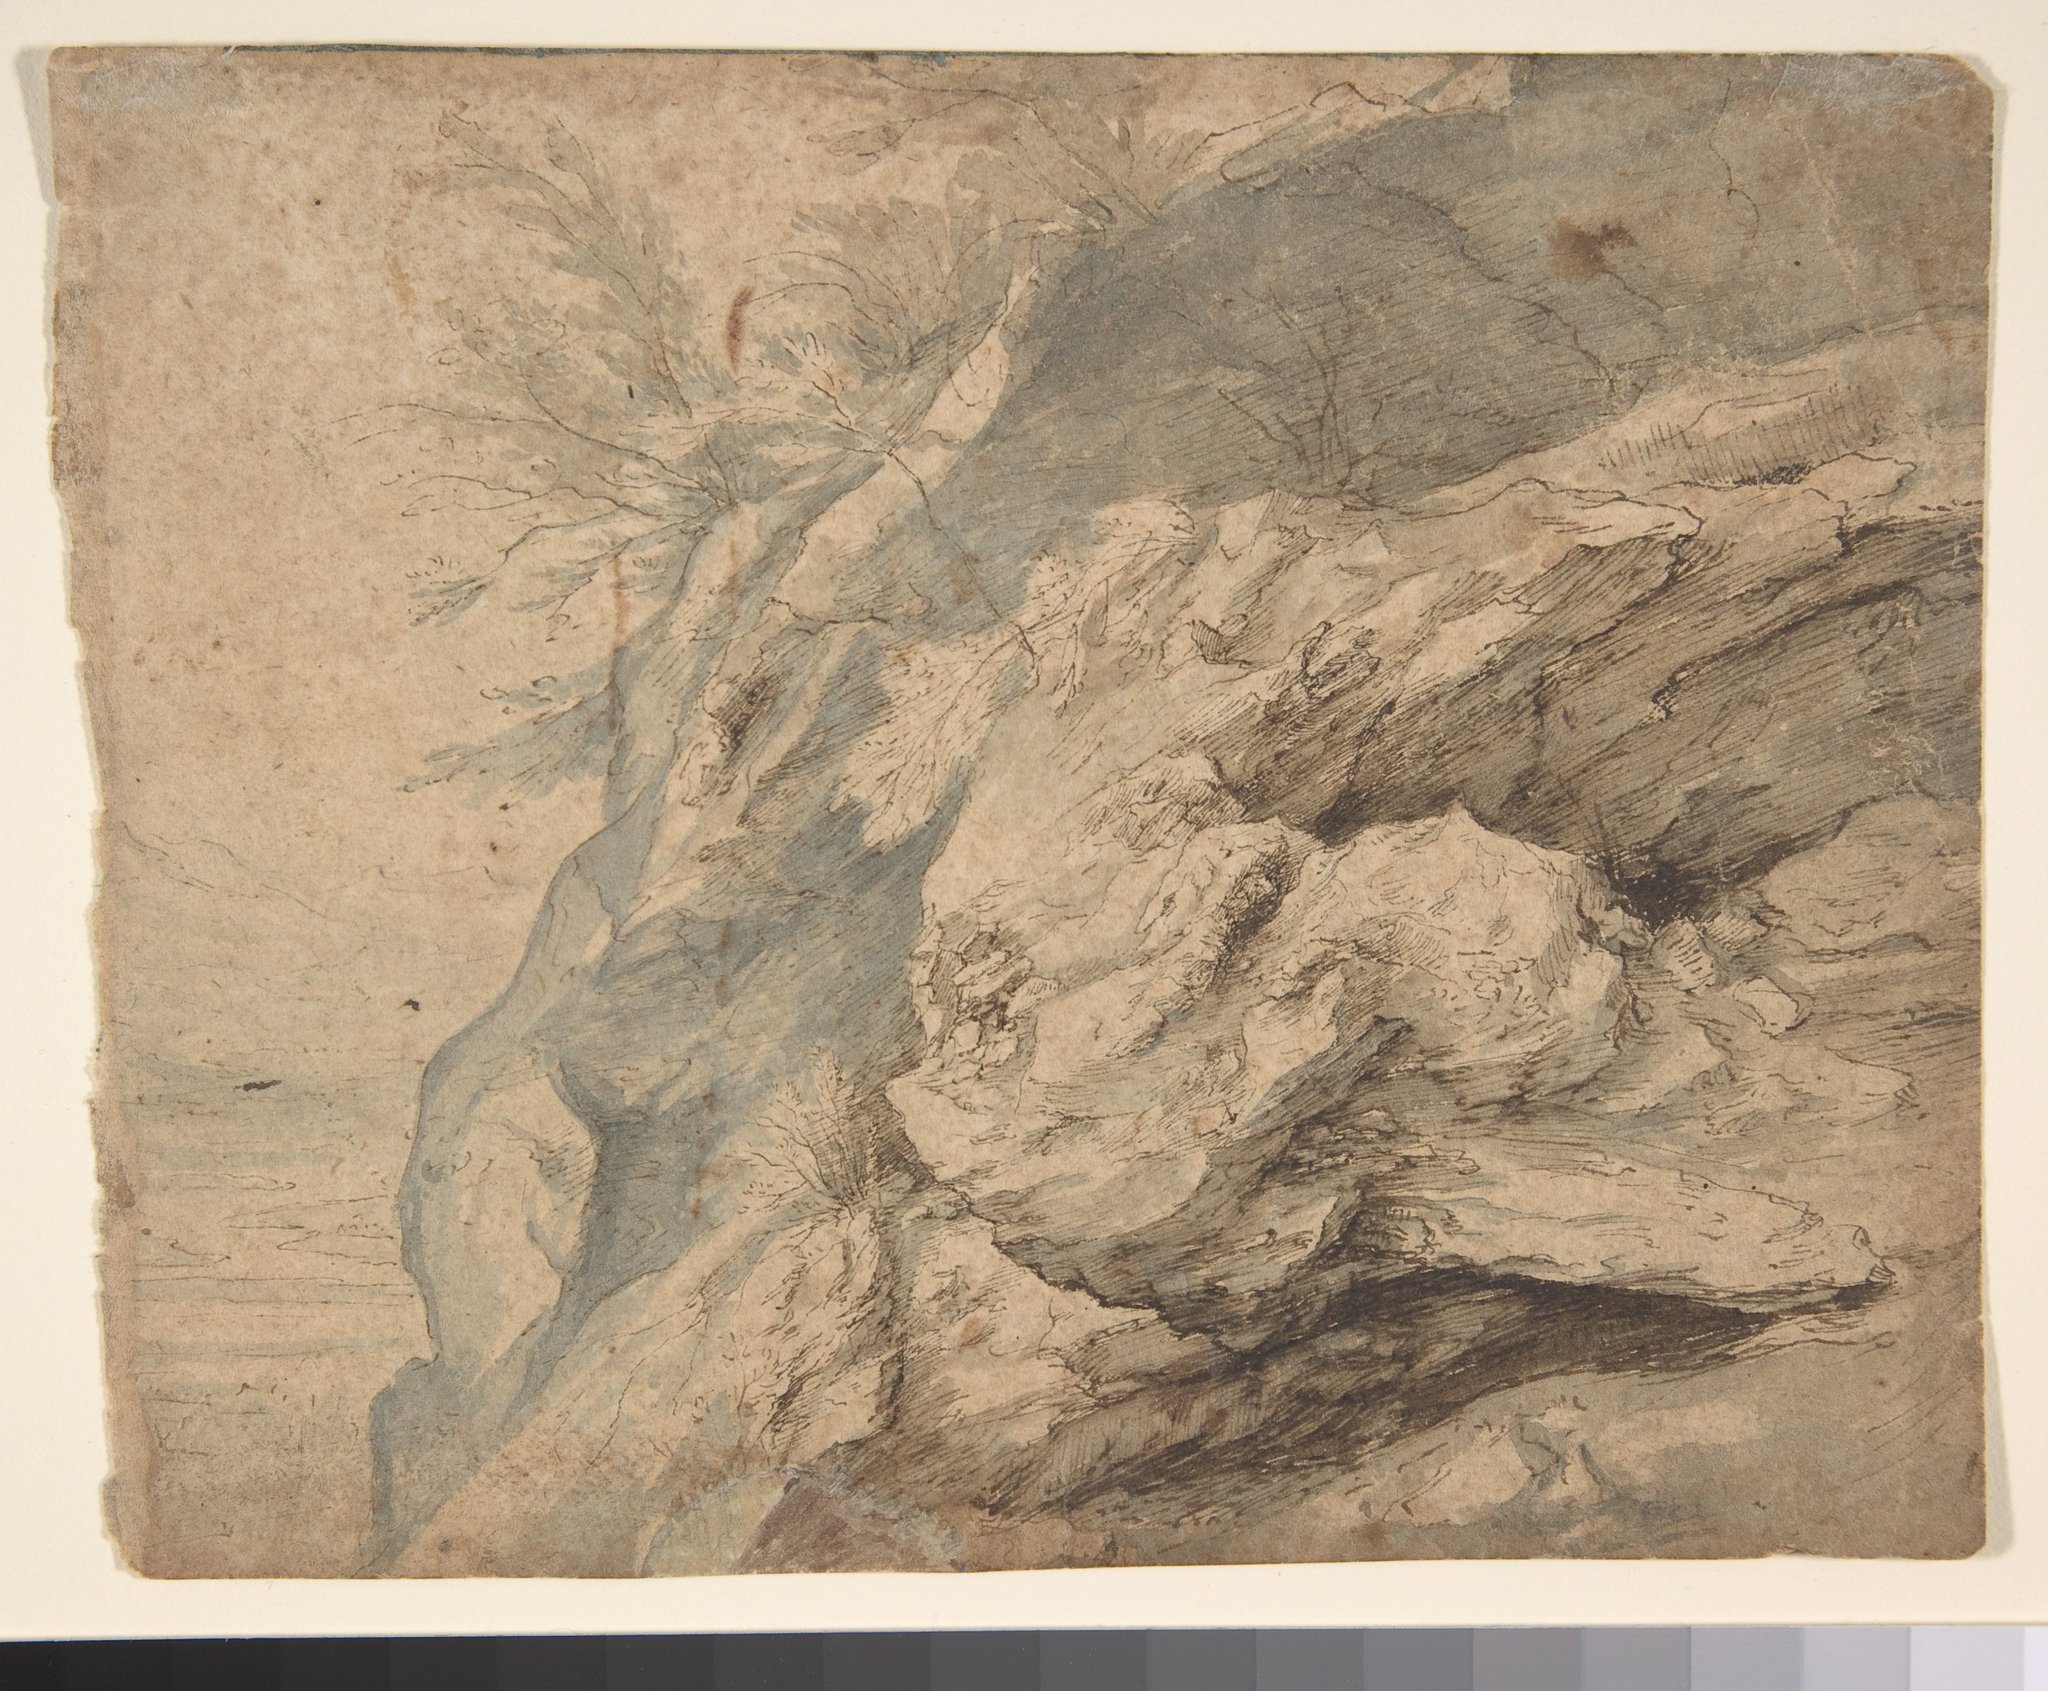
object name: drawing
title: Study of the Side of a Rocky Cliff; Verso: Dam on a Mountain Stream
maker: paulus willemsz. van vianen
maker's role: artist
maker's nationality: netherlandish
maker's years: 1565-1619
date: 1600-1605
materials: ink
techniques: pen, wash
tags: mountains